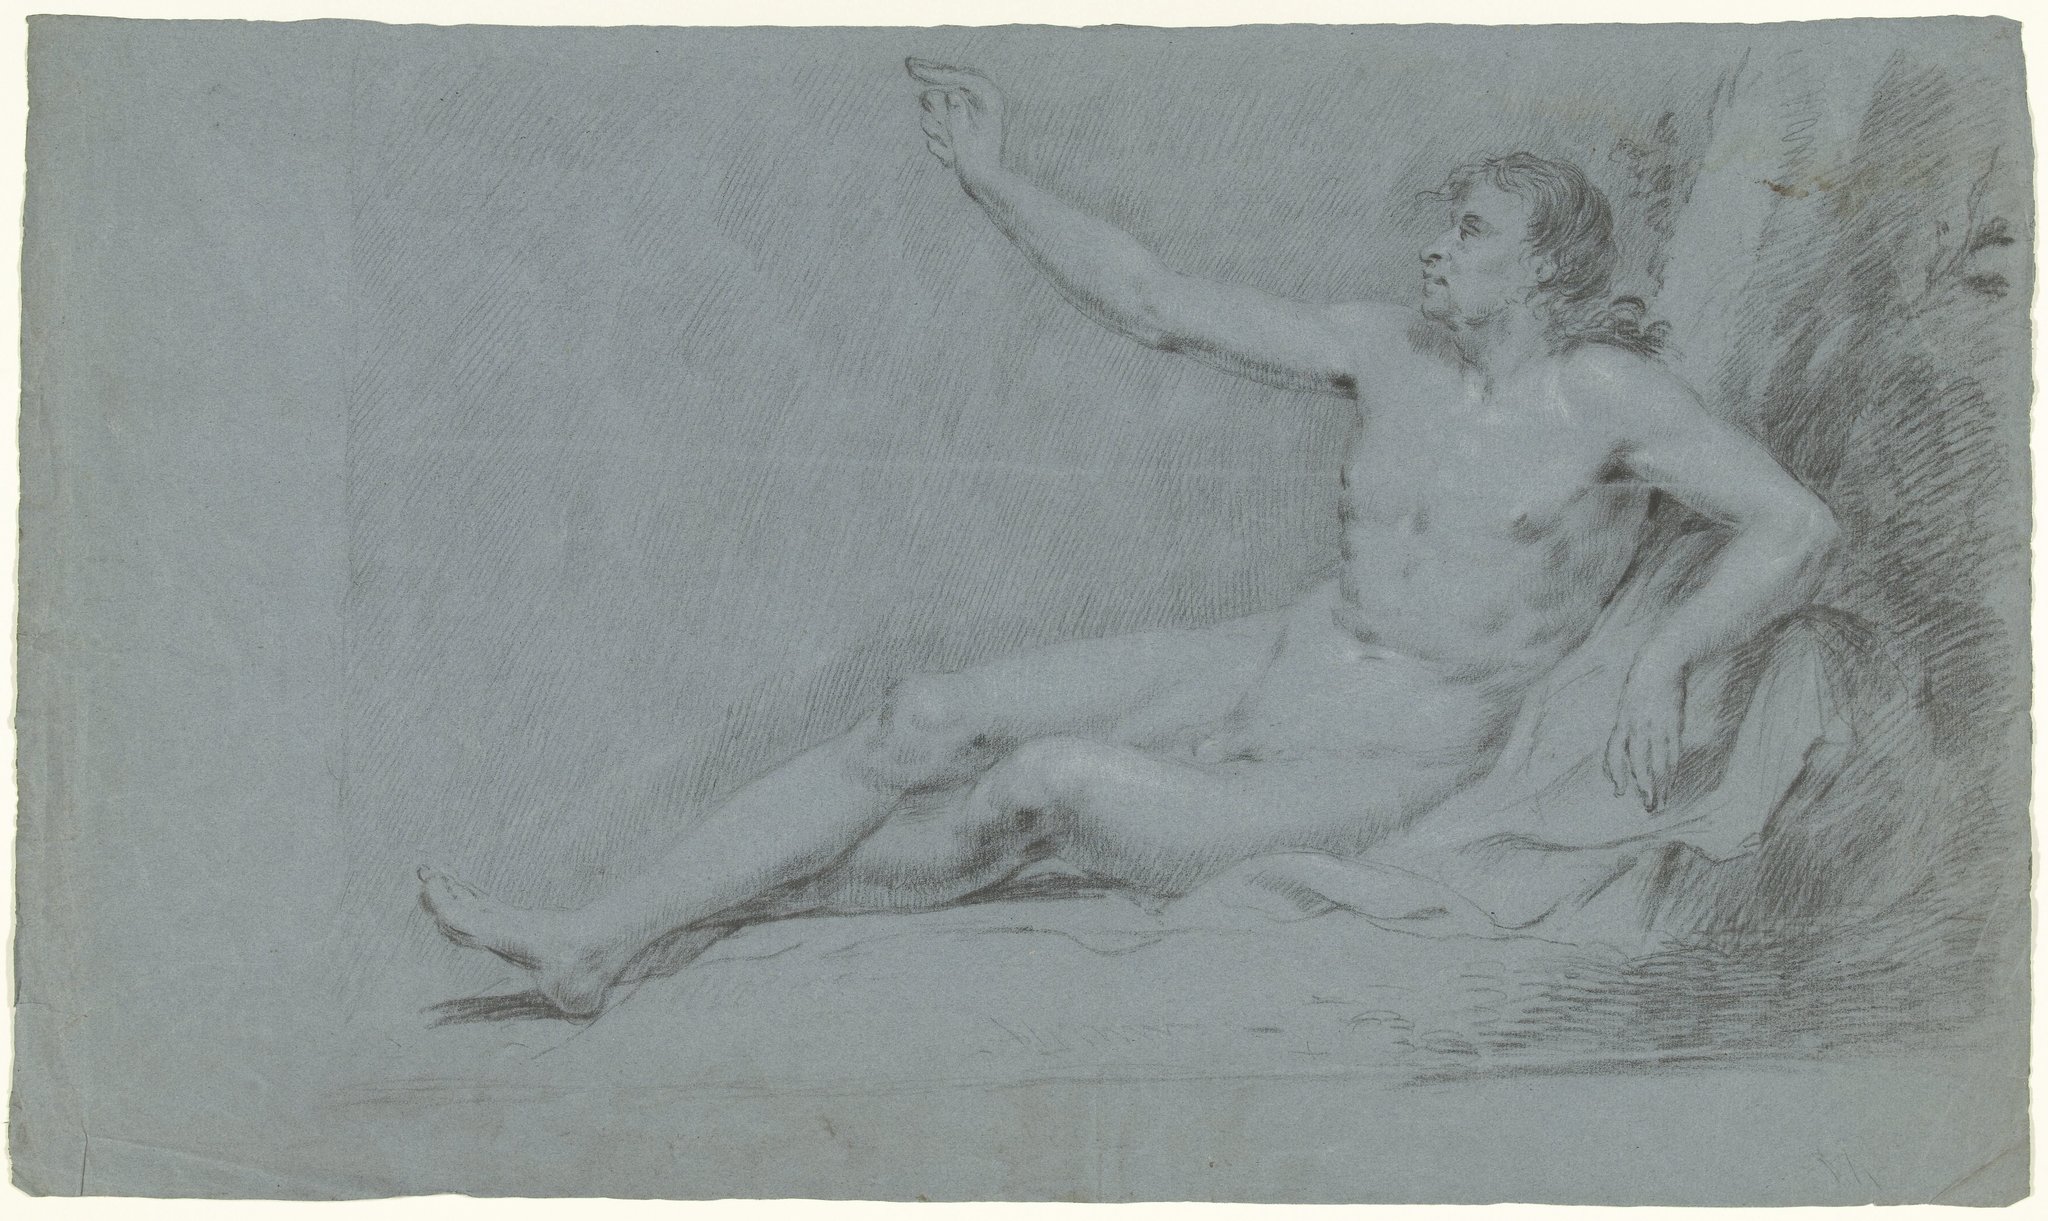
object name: drawing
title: Liggend mannelijk naakt, de rechterarm opgeheven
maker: Anonymous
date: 1700-1800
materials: chalk, paper